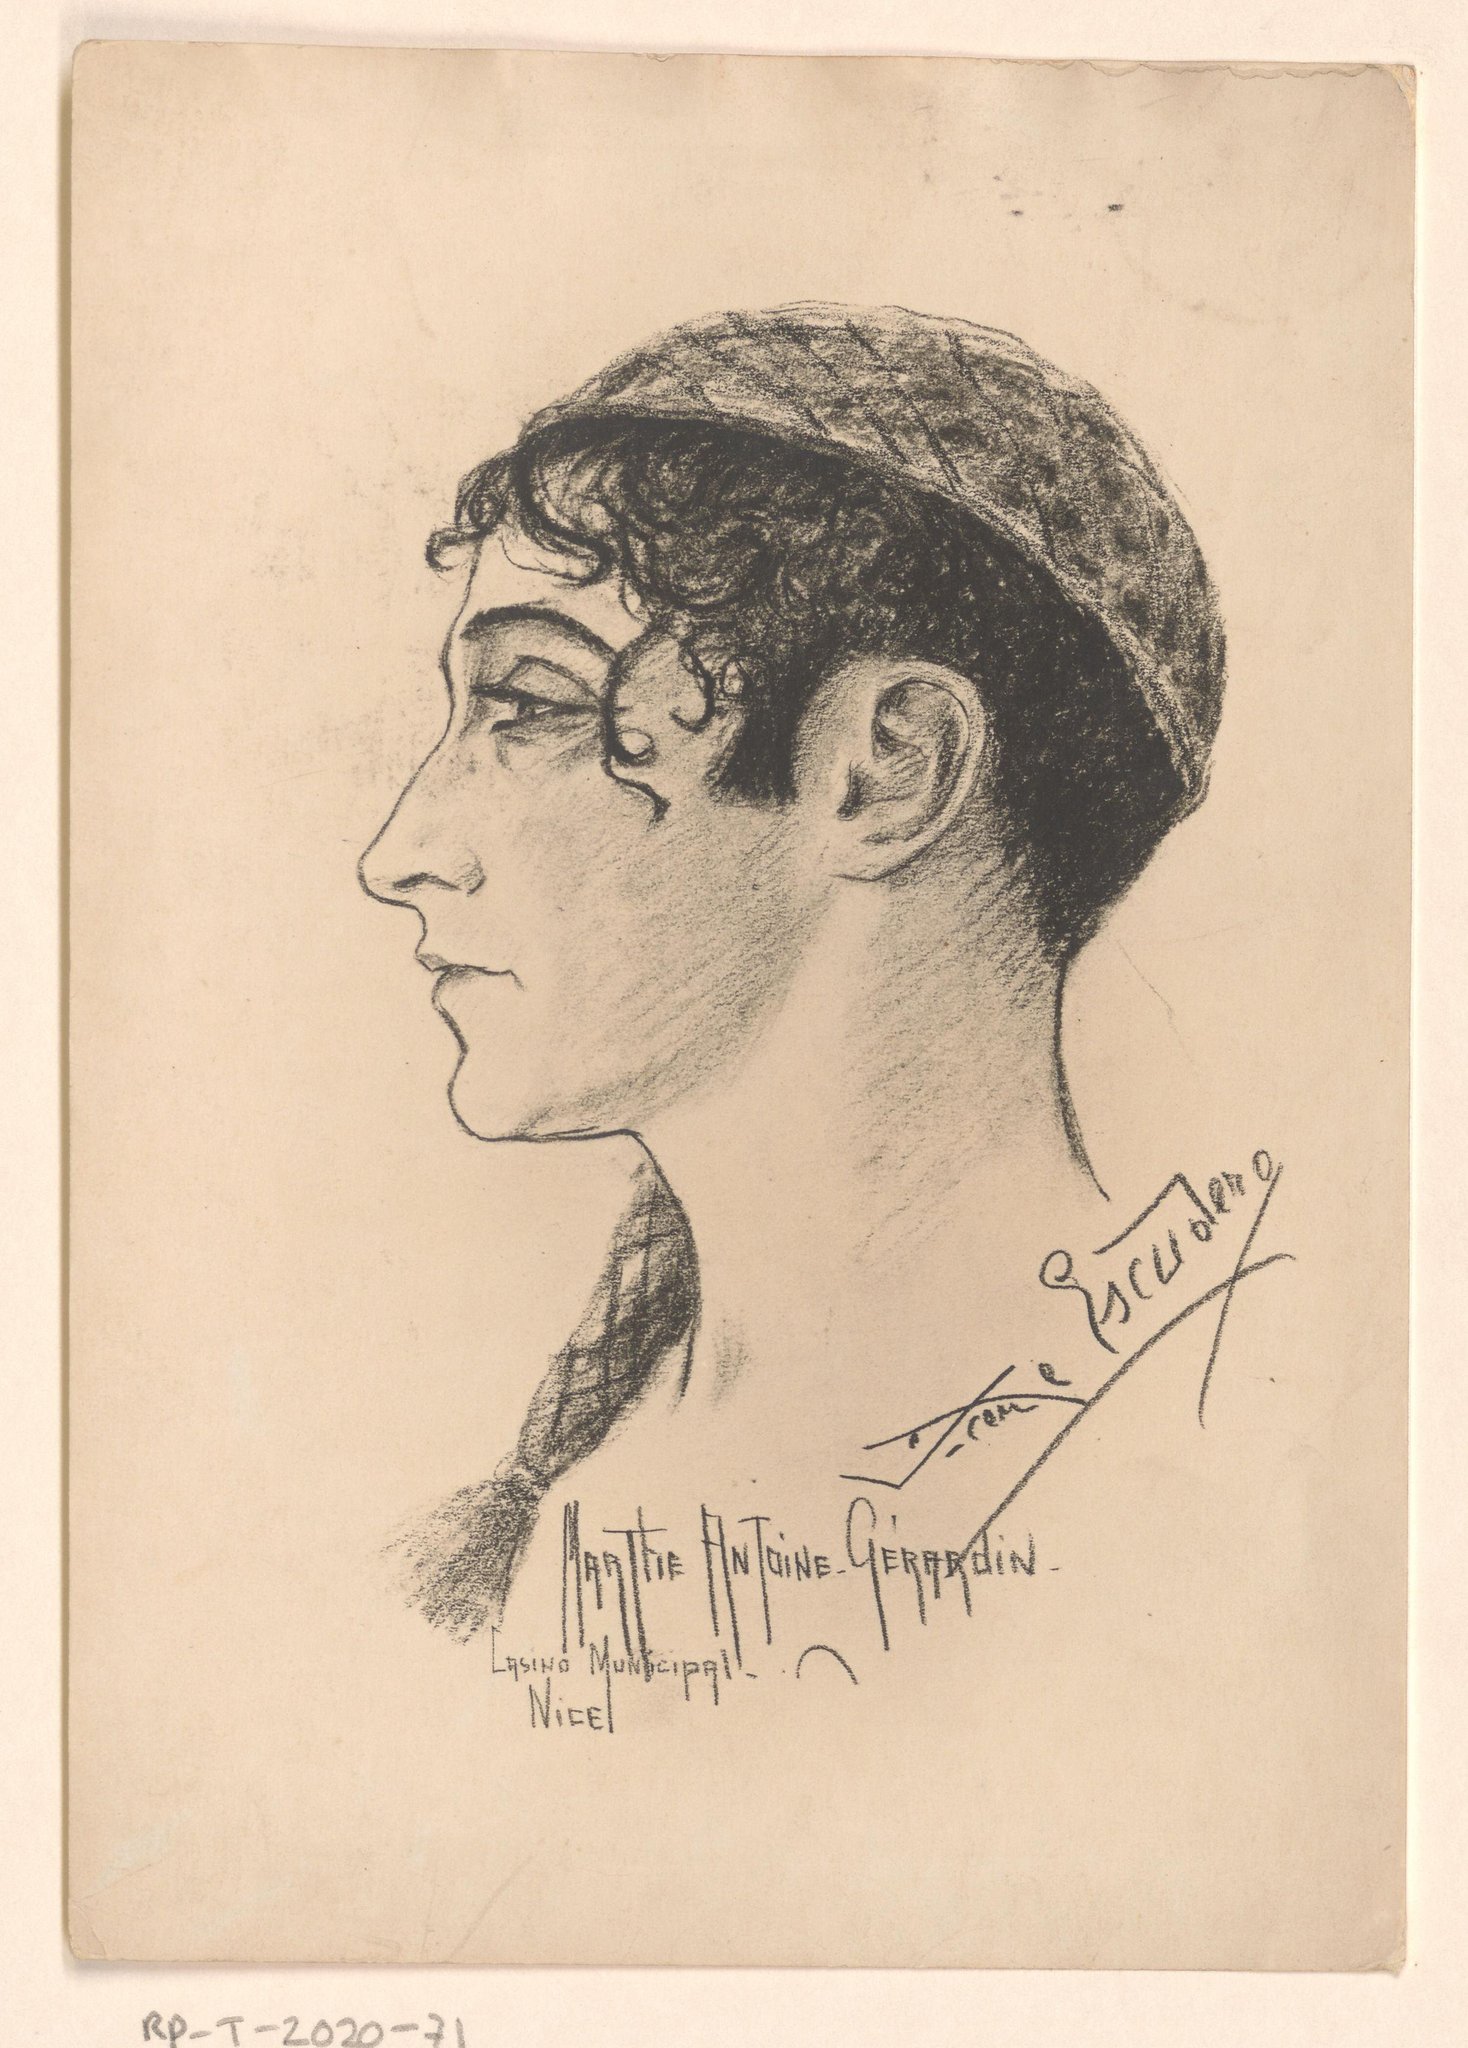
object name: drawing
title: Portret van Vicente Escudero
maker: marthe antoine gérardin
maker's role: draughtsman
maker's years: 1884-1952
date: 1920-1952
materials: chalk, paper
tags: historical persons, portrait of dancer